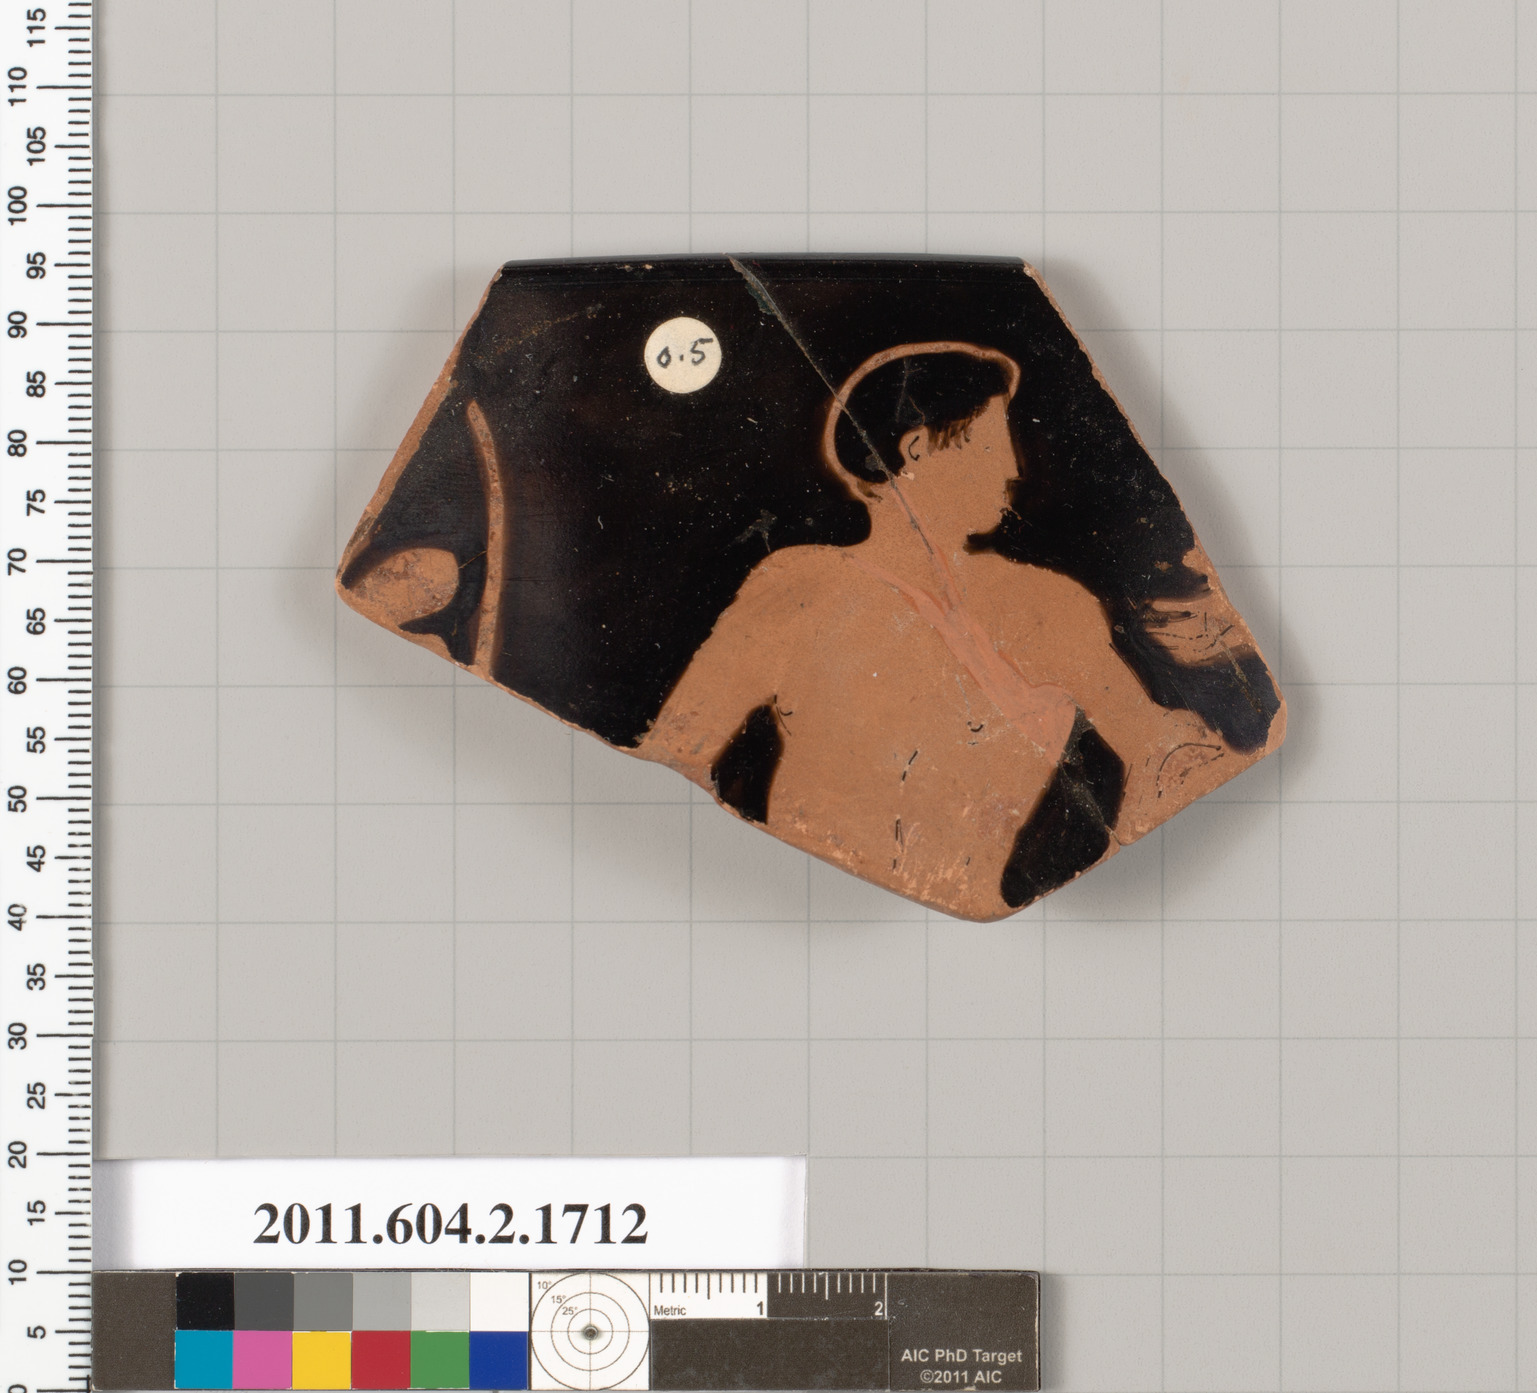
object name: skyphos fragment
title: Terracotta rim fragment of a skyphos (deep drinking cup)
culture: greek, attic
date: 475-451 BCE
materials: terracotta